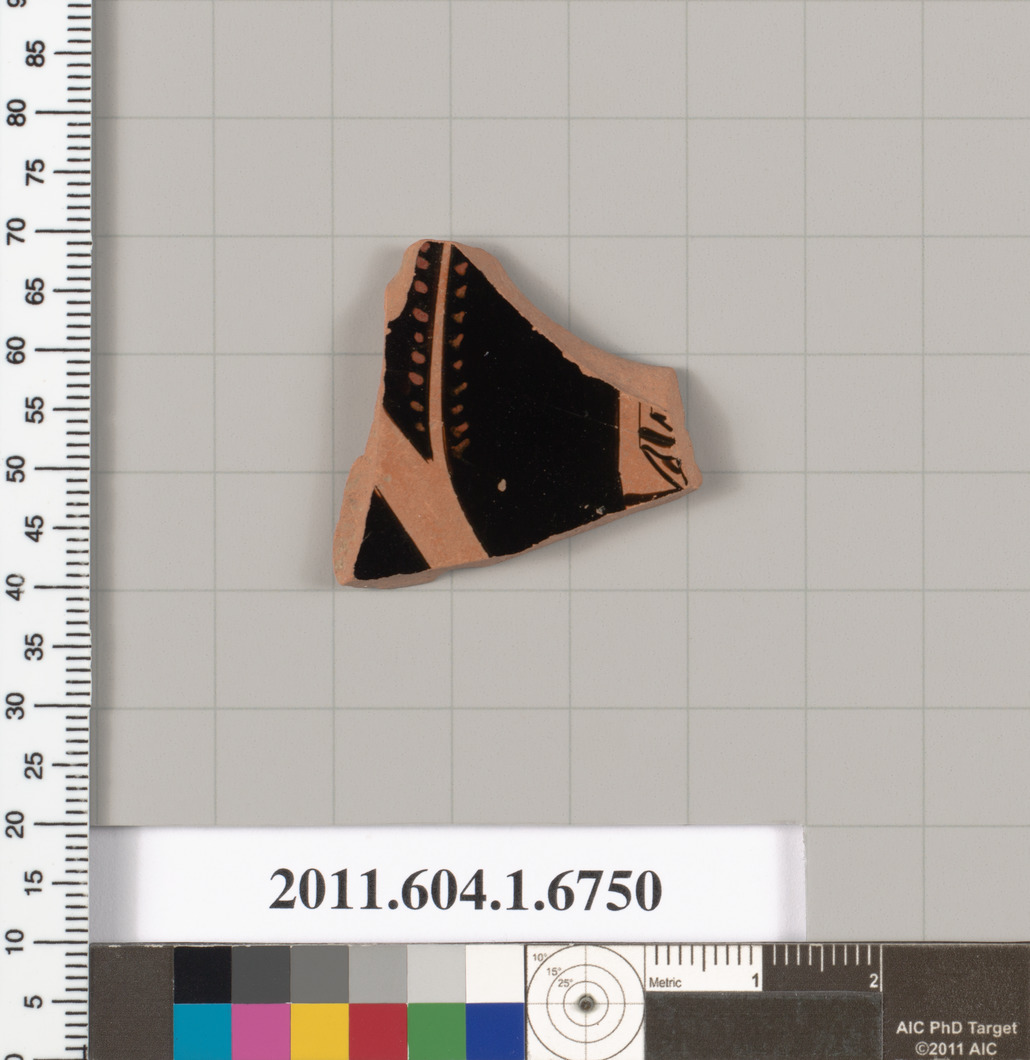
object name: kylix fragment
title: Terracotta fragment of a kylix (drinking cup)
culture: greek, attic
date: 490-470 BCE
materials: terracotta